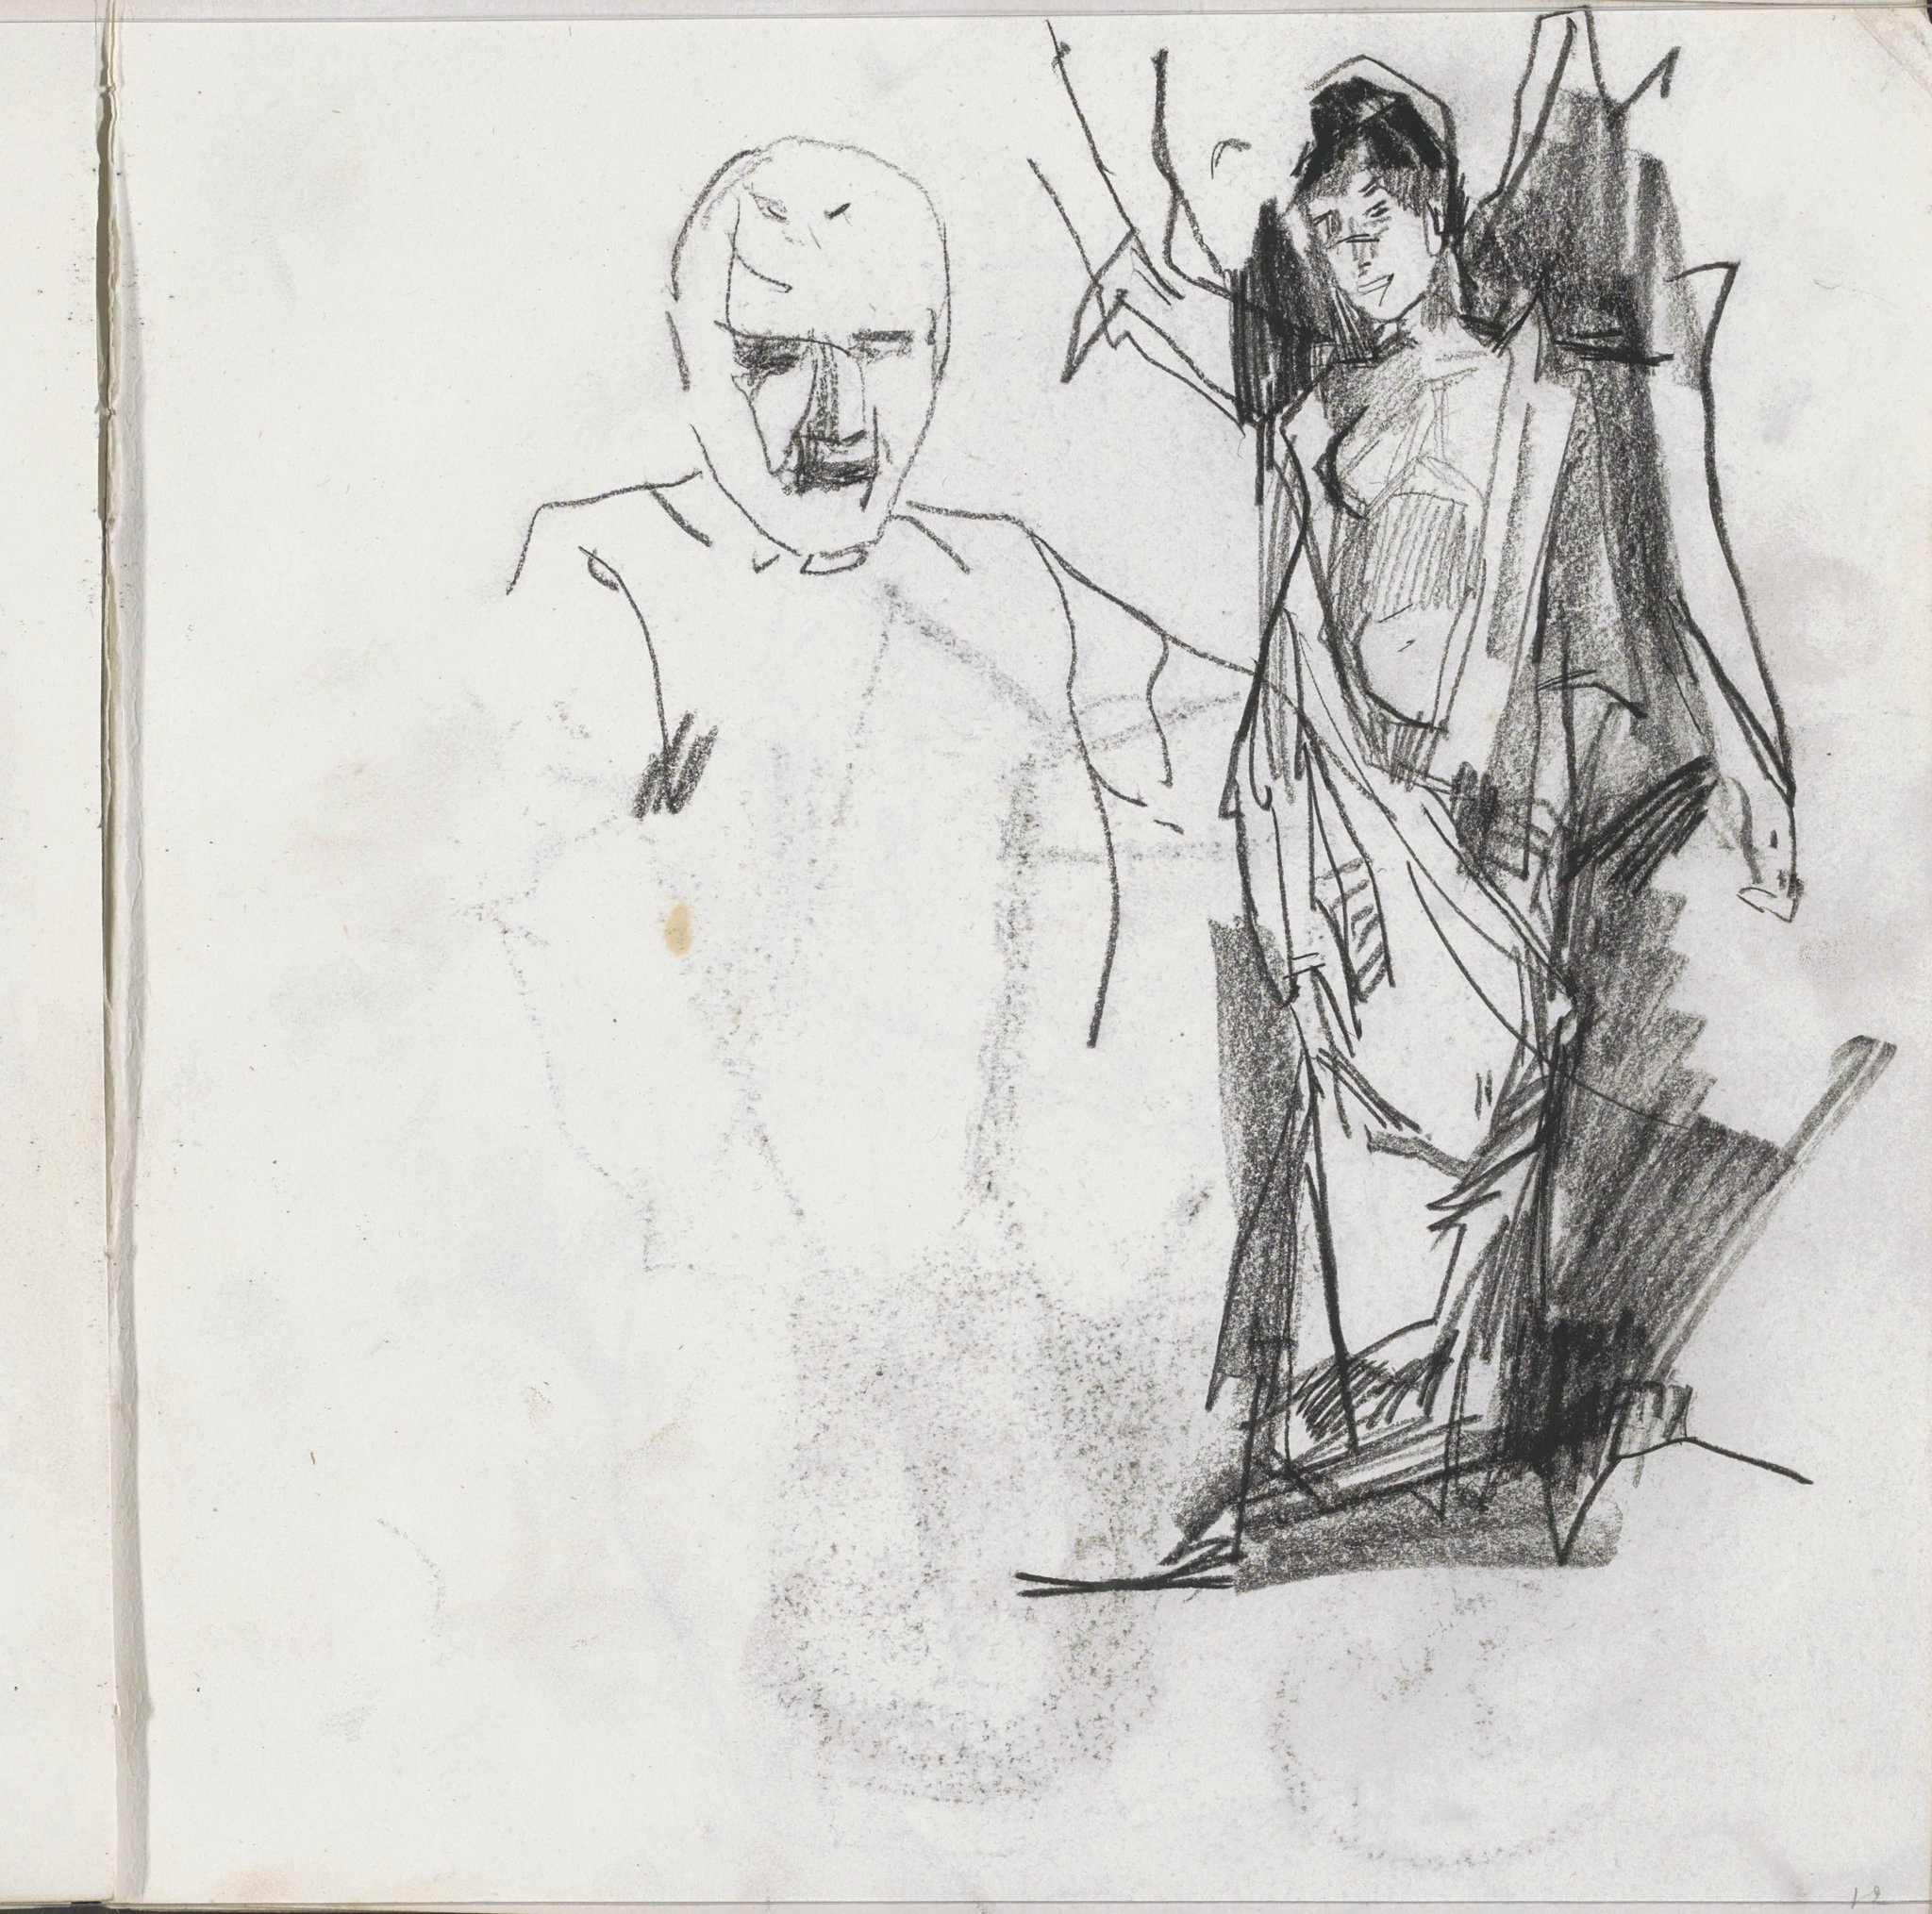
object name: sketchbook leaf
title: Studieblad met een man en een vrouw met ontbloot bovenlijf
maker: isaac israels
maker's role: draughtsman, painter, print maker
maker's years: 1865-1934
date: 1875-1934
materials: chalk, paper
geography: the hague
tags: adult man, adult woman (+ standing)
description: Blad 12 recto uit schetsboek IX met 28 bladen.